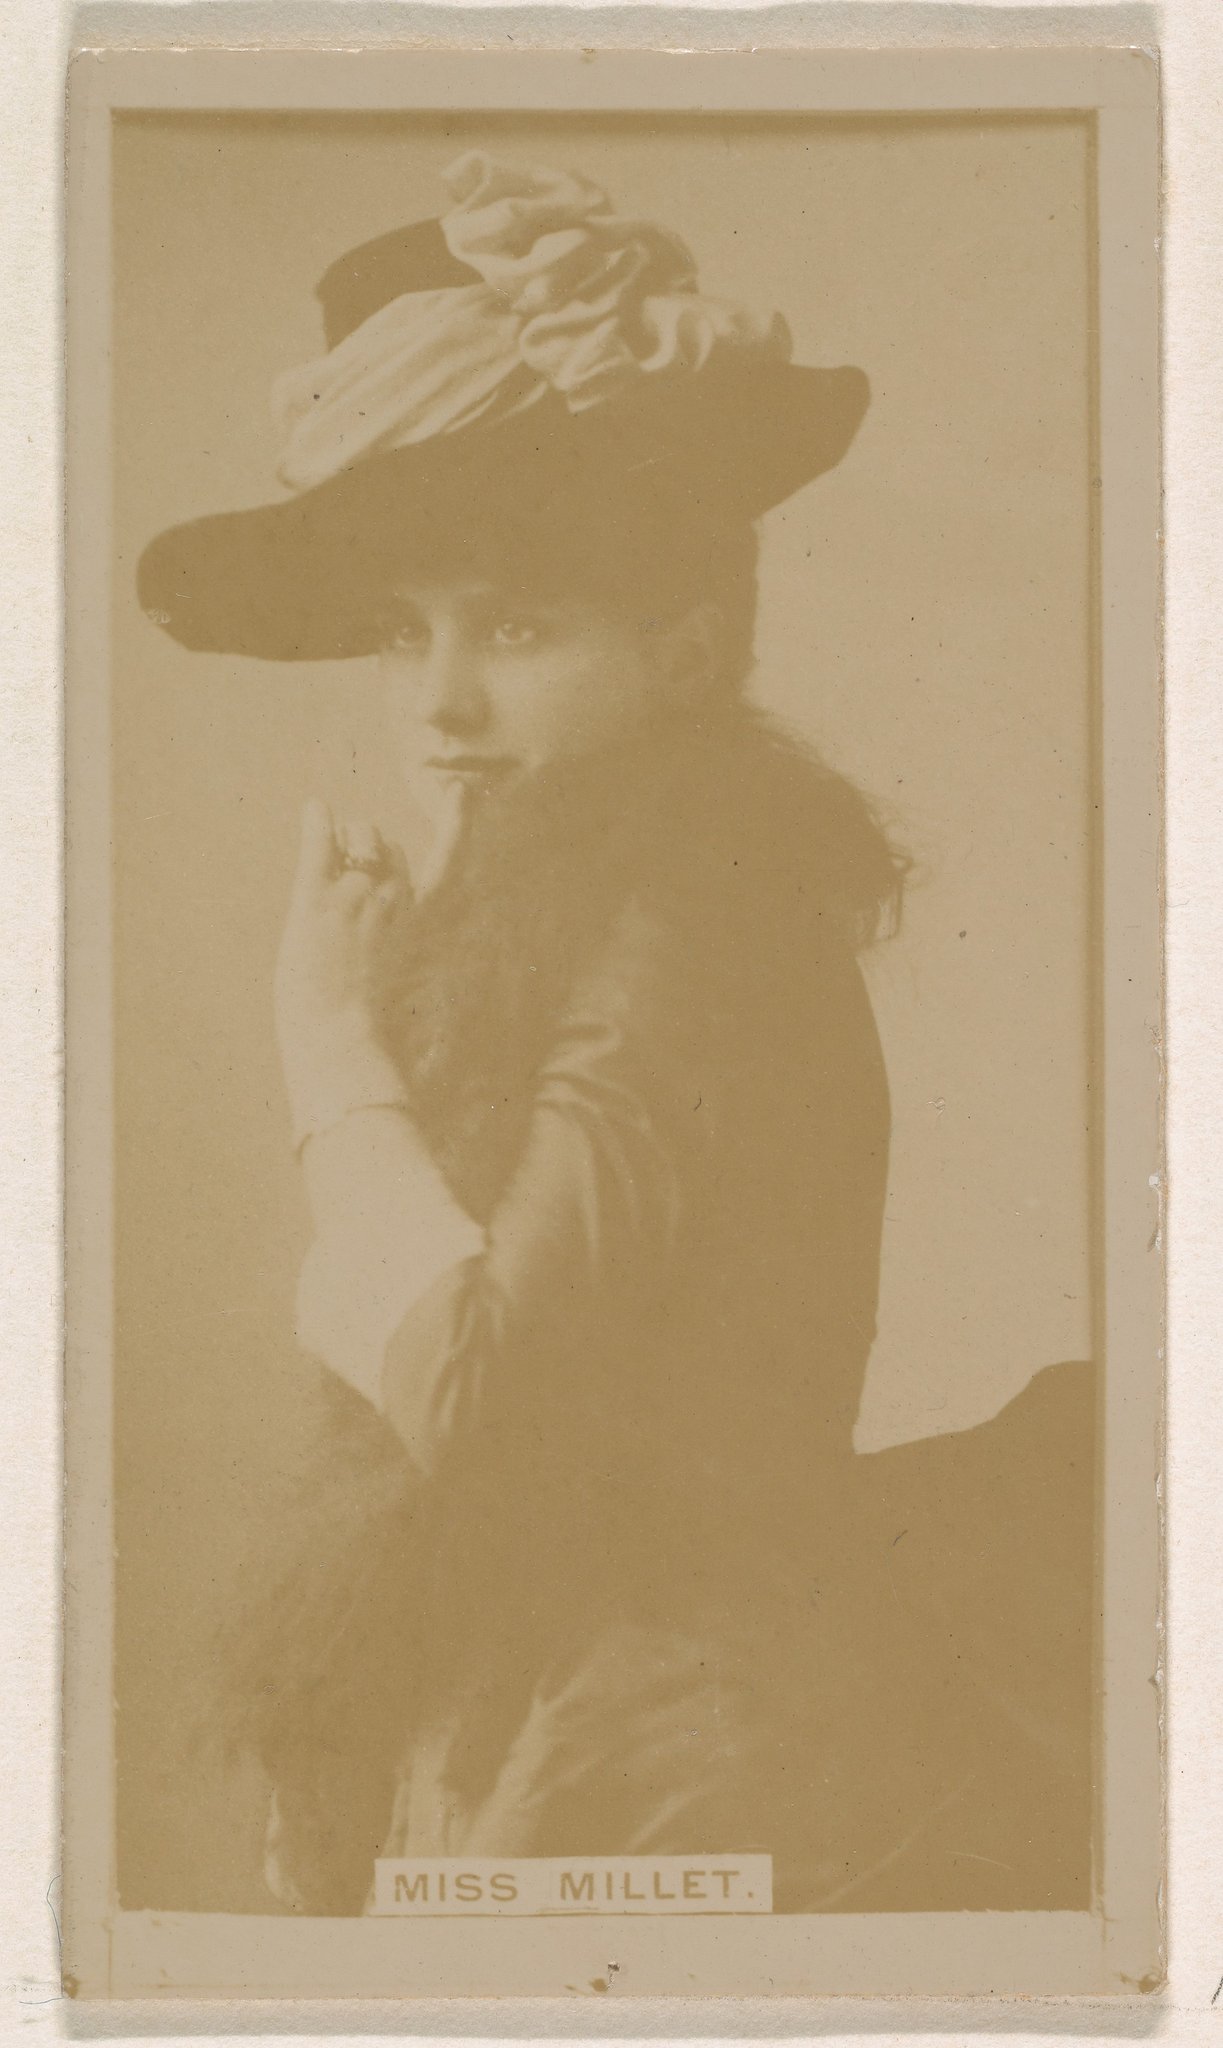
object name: photograph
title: Miss Millet, from the Actresses series (N245) issued by Kinney Brothers to promote Sweet Caporal Cigarettes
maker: kinney brothers tobacco company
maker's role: publisher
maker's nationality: american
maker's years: 1869-2011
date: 1890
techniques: albumen silver print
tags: portraits,women,actresses